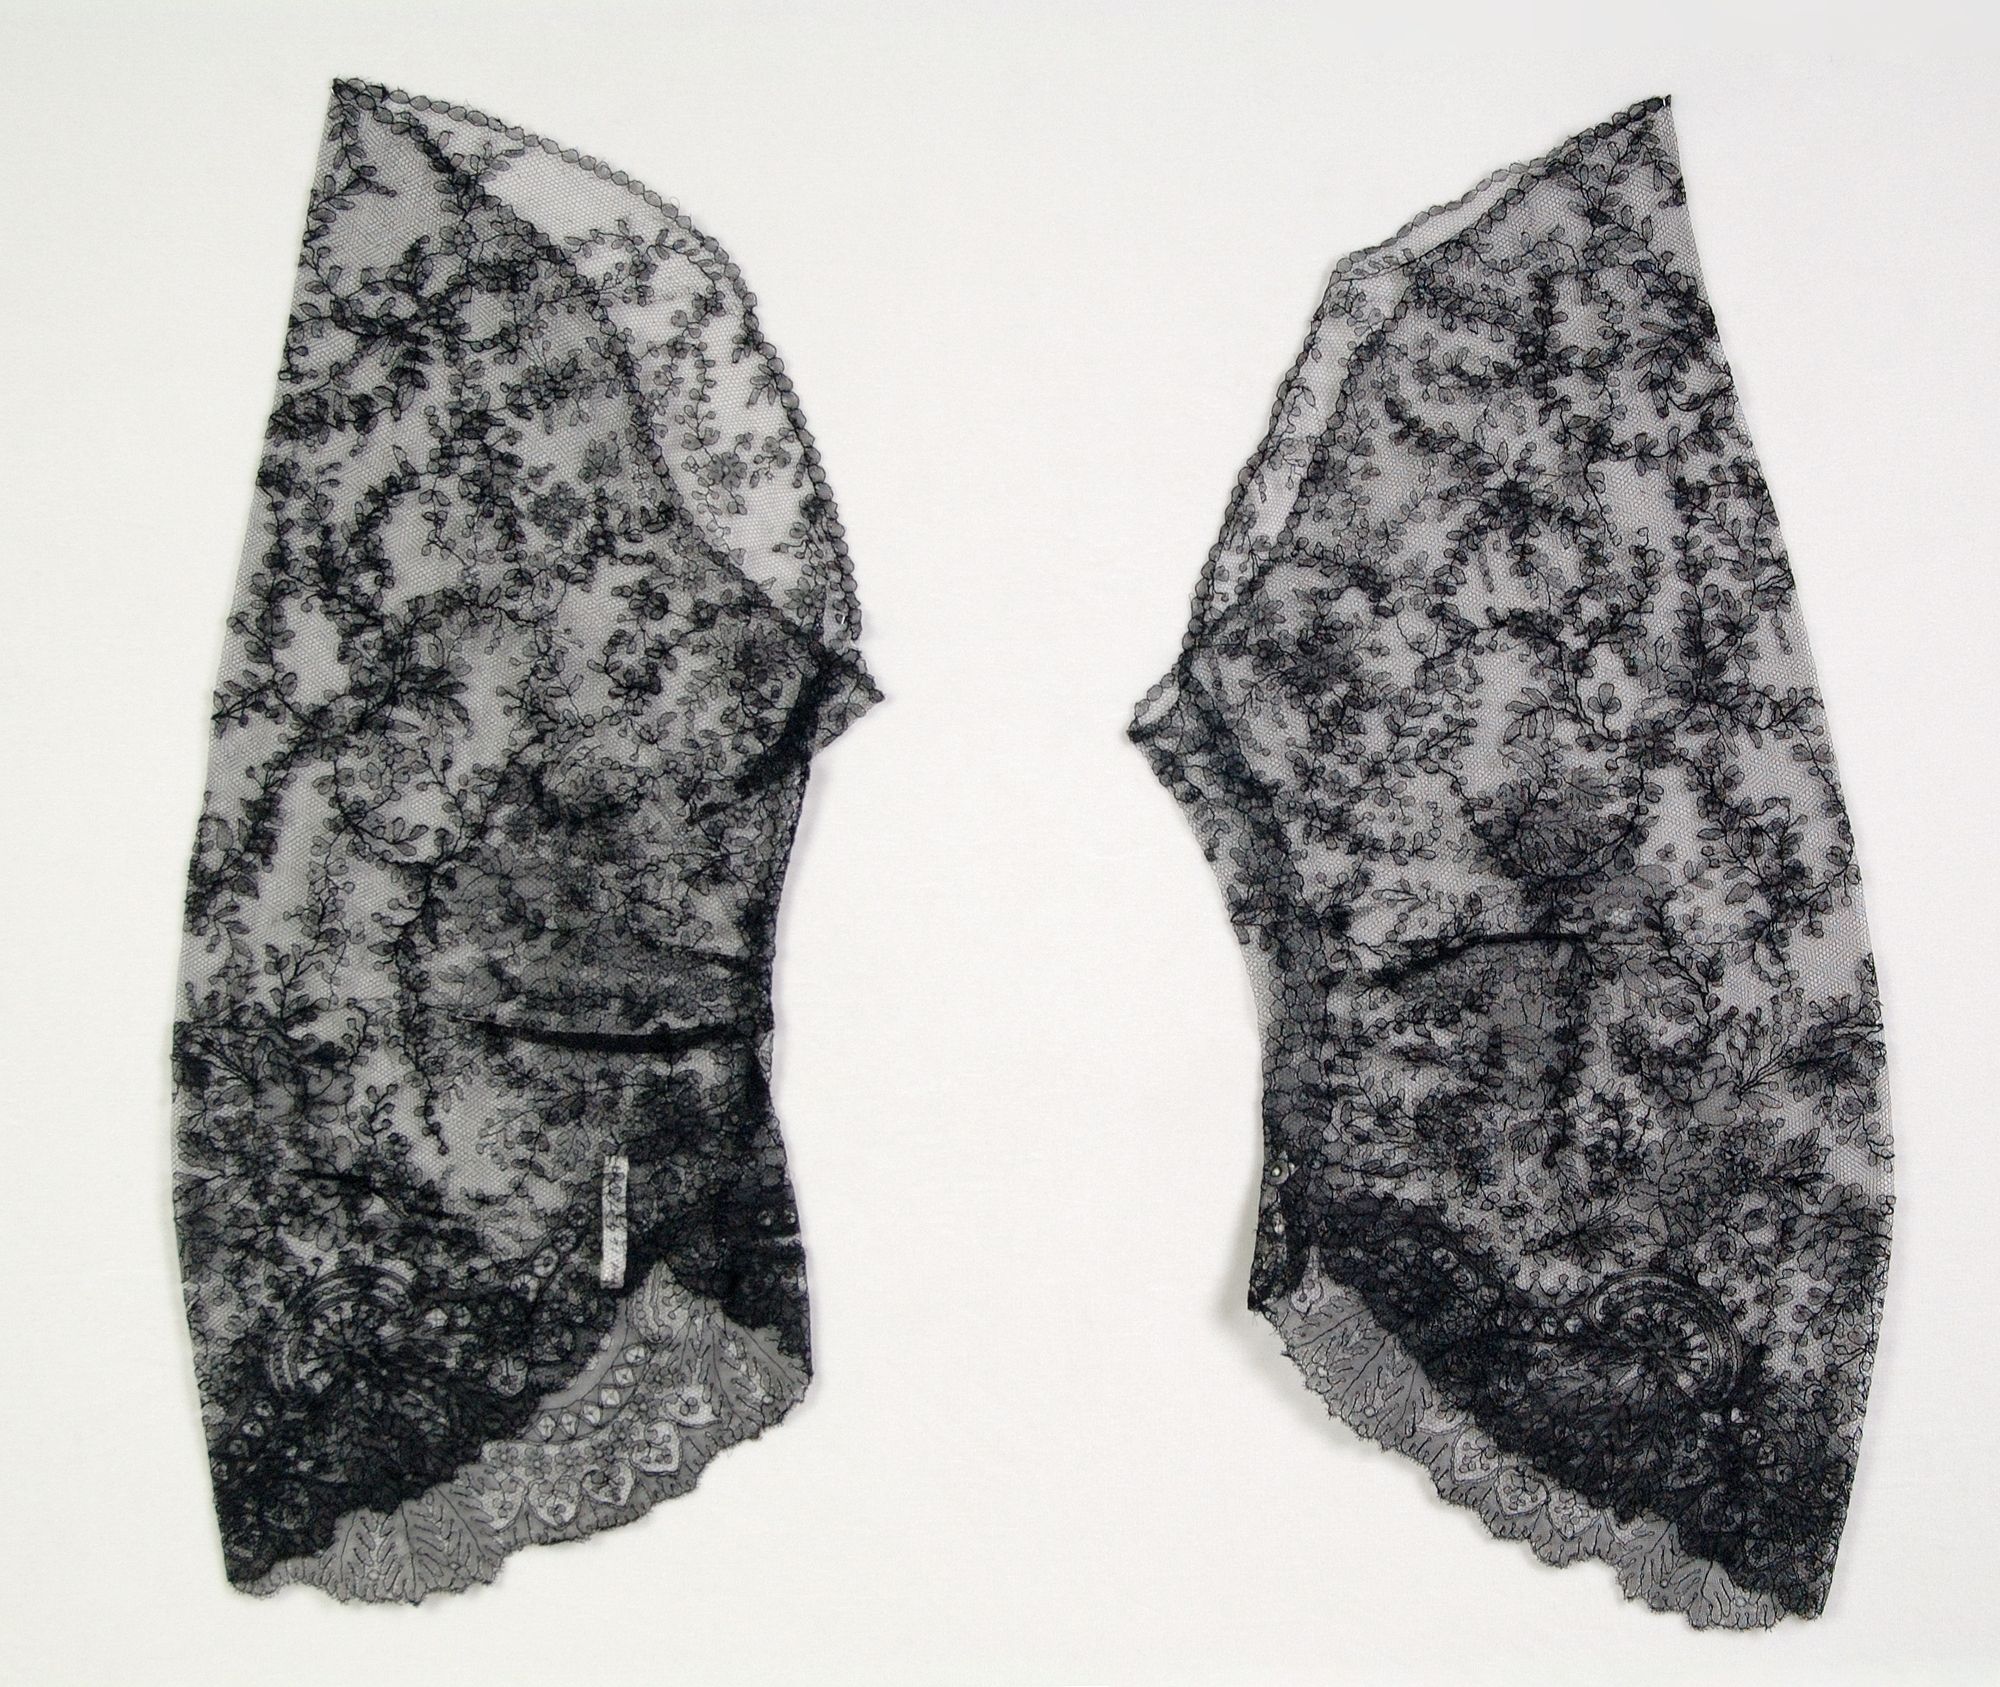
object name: sleeve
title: Sleeves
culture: american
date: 1876-1900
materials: silk